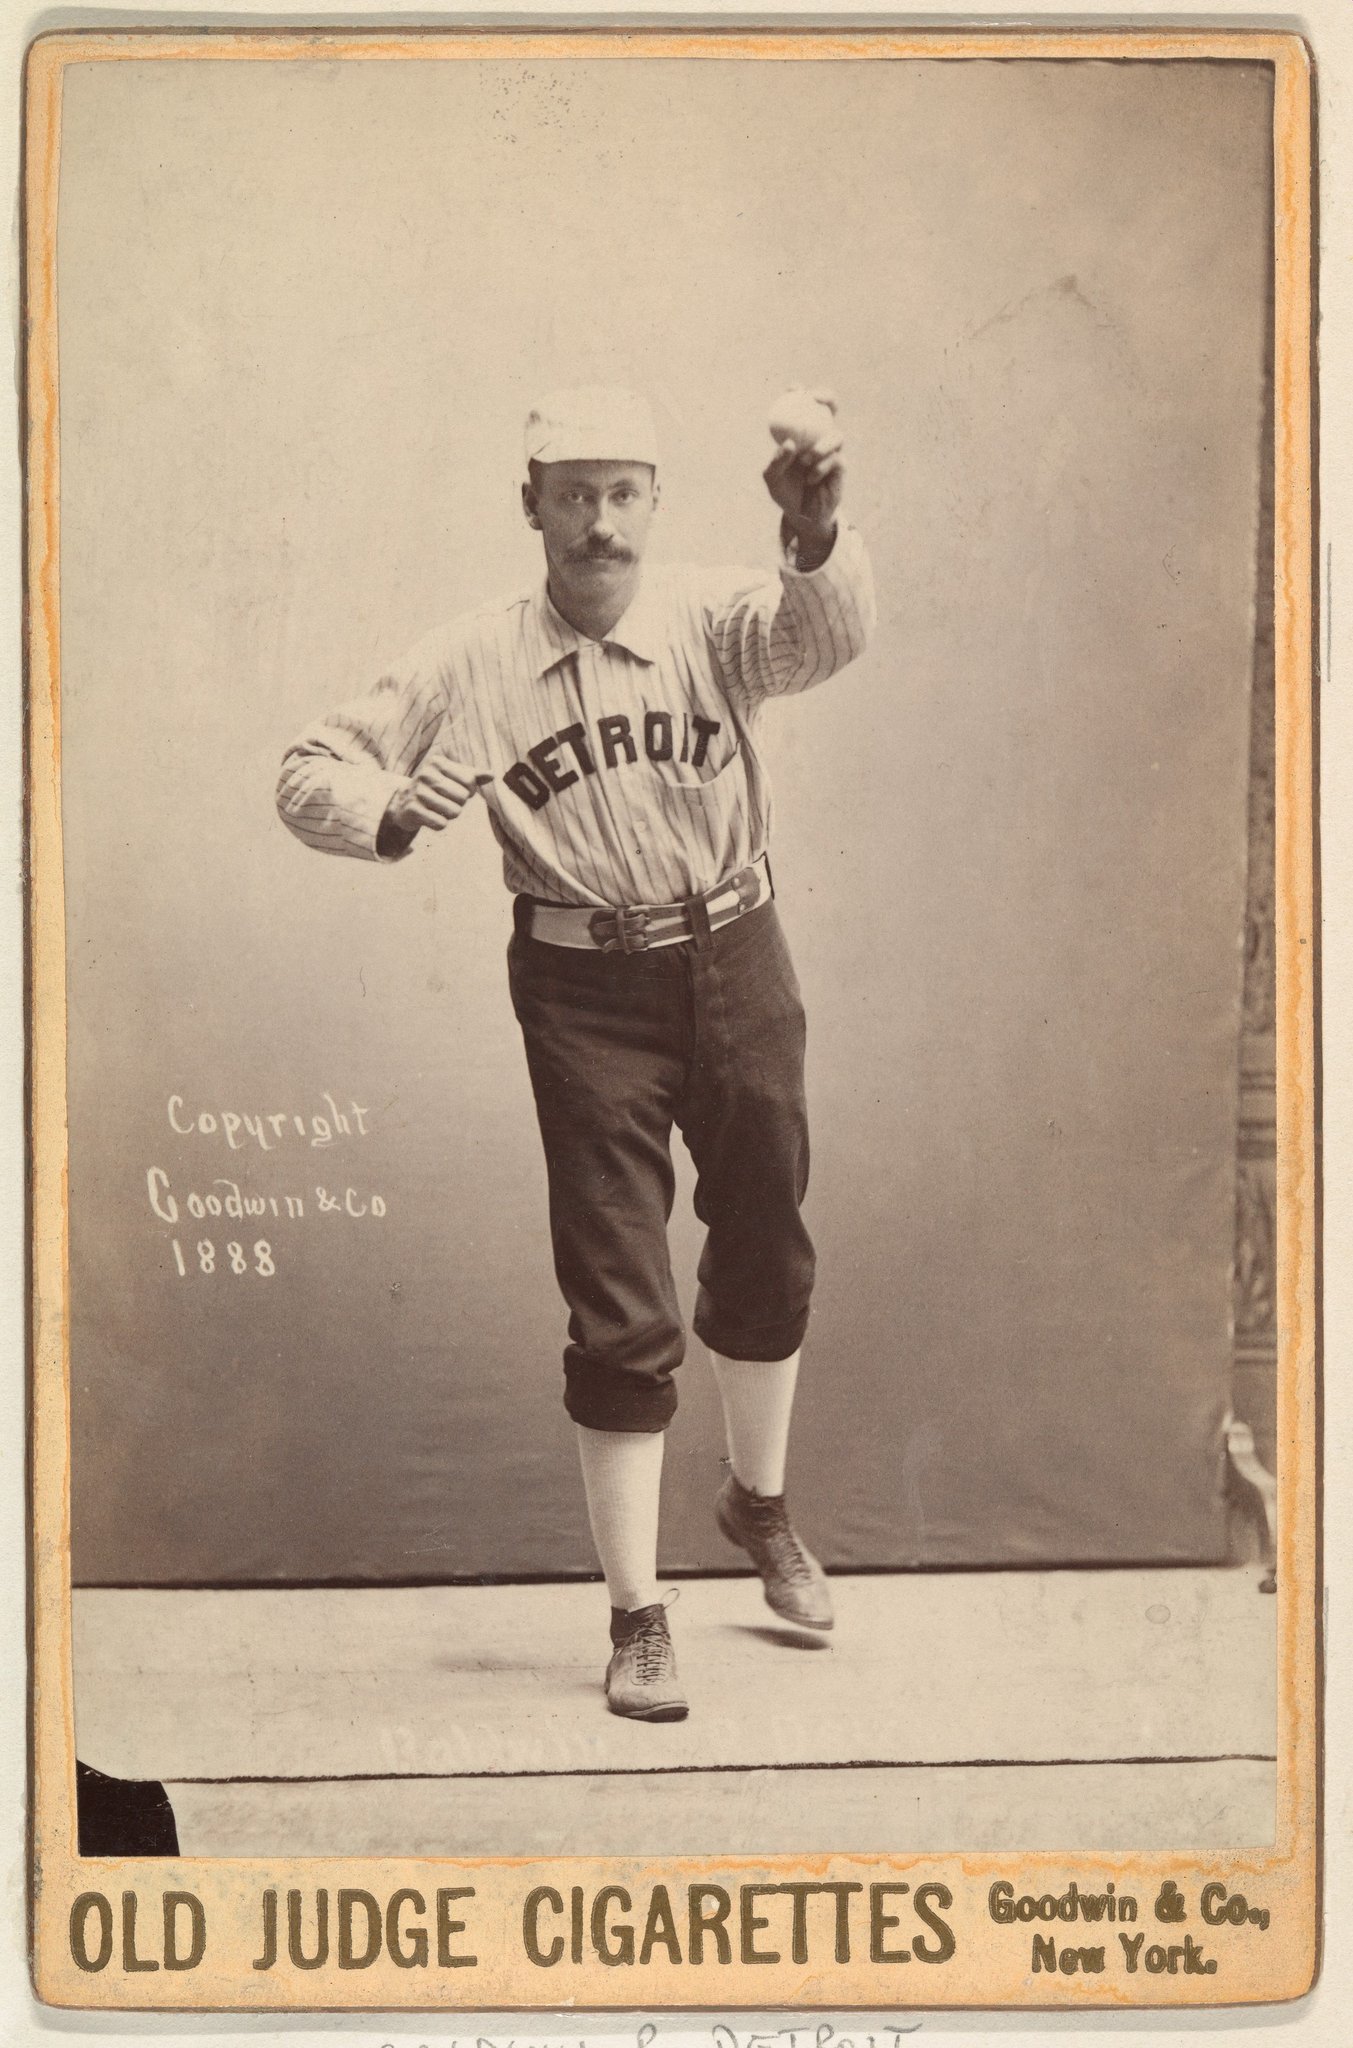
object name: baseball card, photograph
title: Baldwin, Pitcher, Detroit, from the series Old Judge Cigarettes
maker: goodwin & company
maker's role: publisher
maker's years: 1850-1950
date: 1888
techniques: albumen print, photography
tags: men,portraits,baseball,athletes